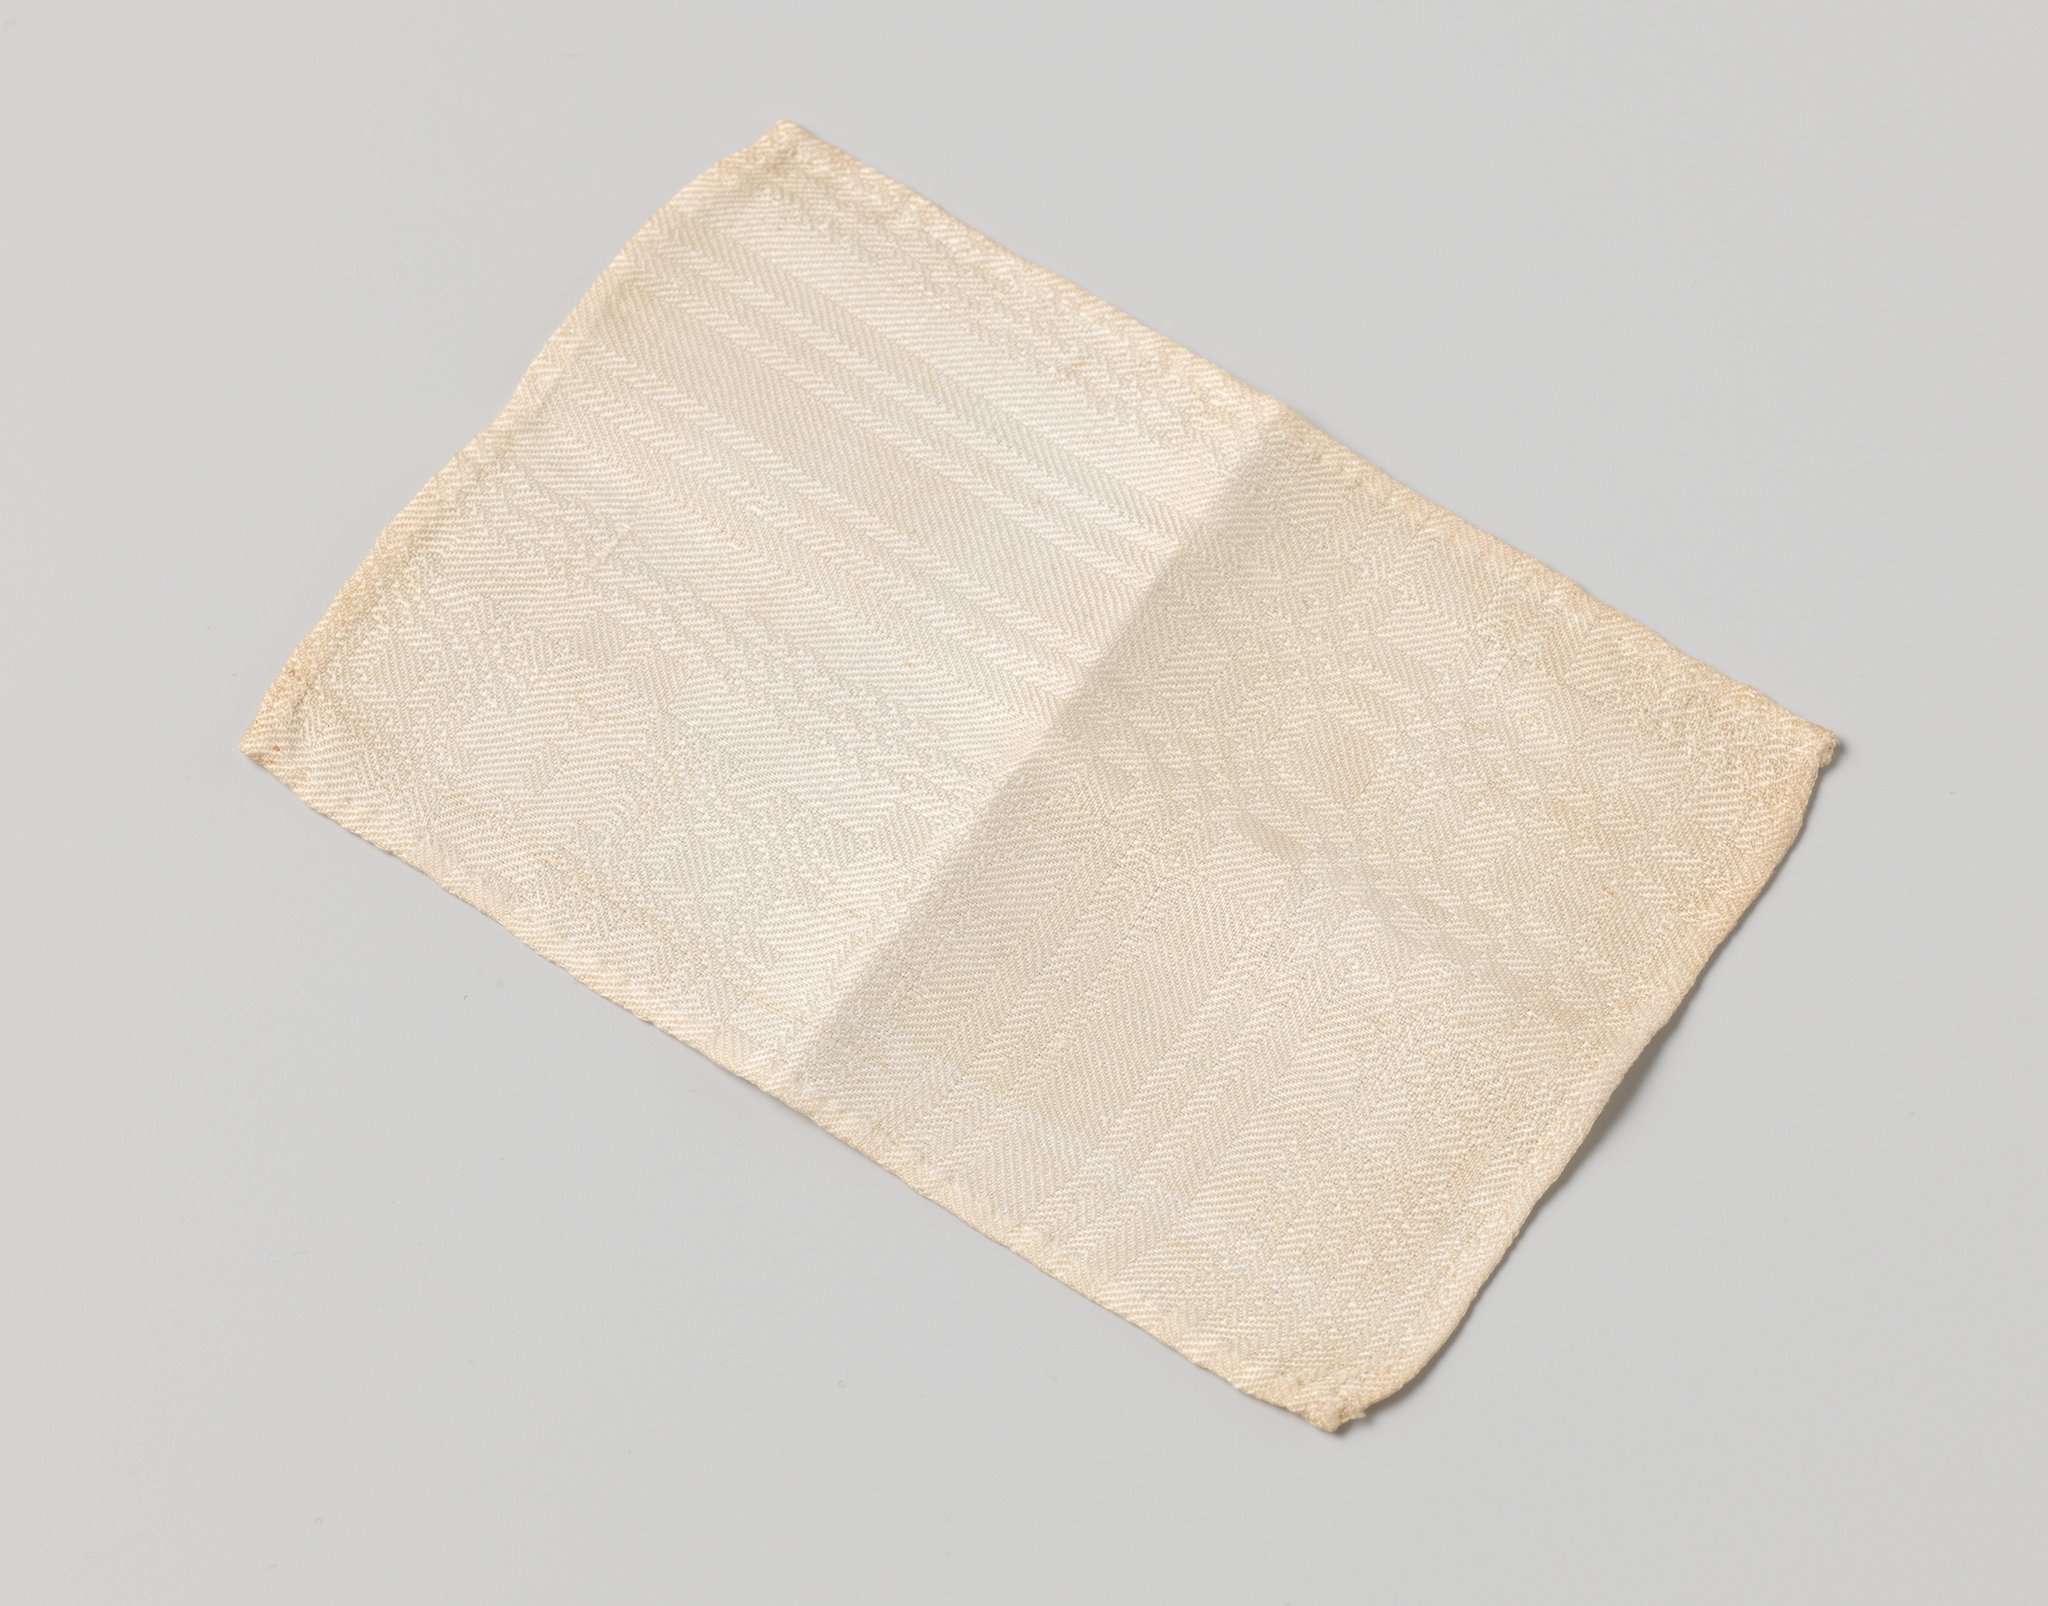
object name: miniature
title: Servet, met ingeweven pellenpatroon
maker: Anonymous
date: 1750-1800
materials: linen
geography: netherlands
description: Servet van linnen met pellenpatroon, geknipt uit grotere lap; aan vier zijden omgezoomd..